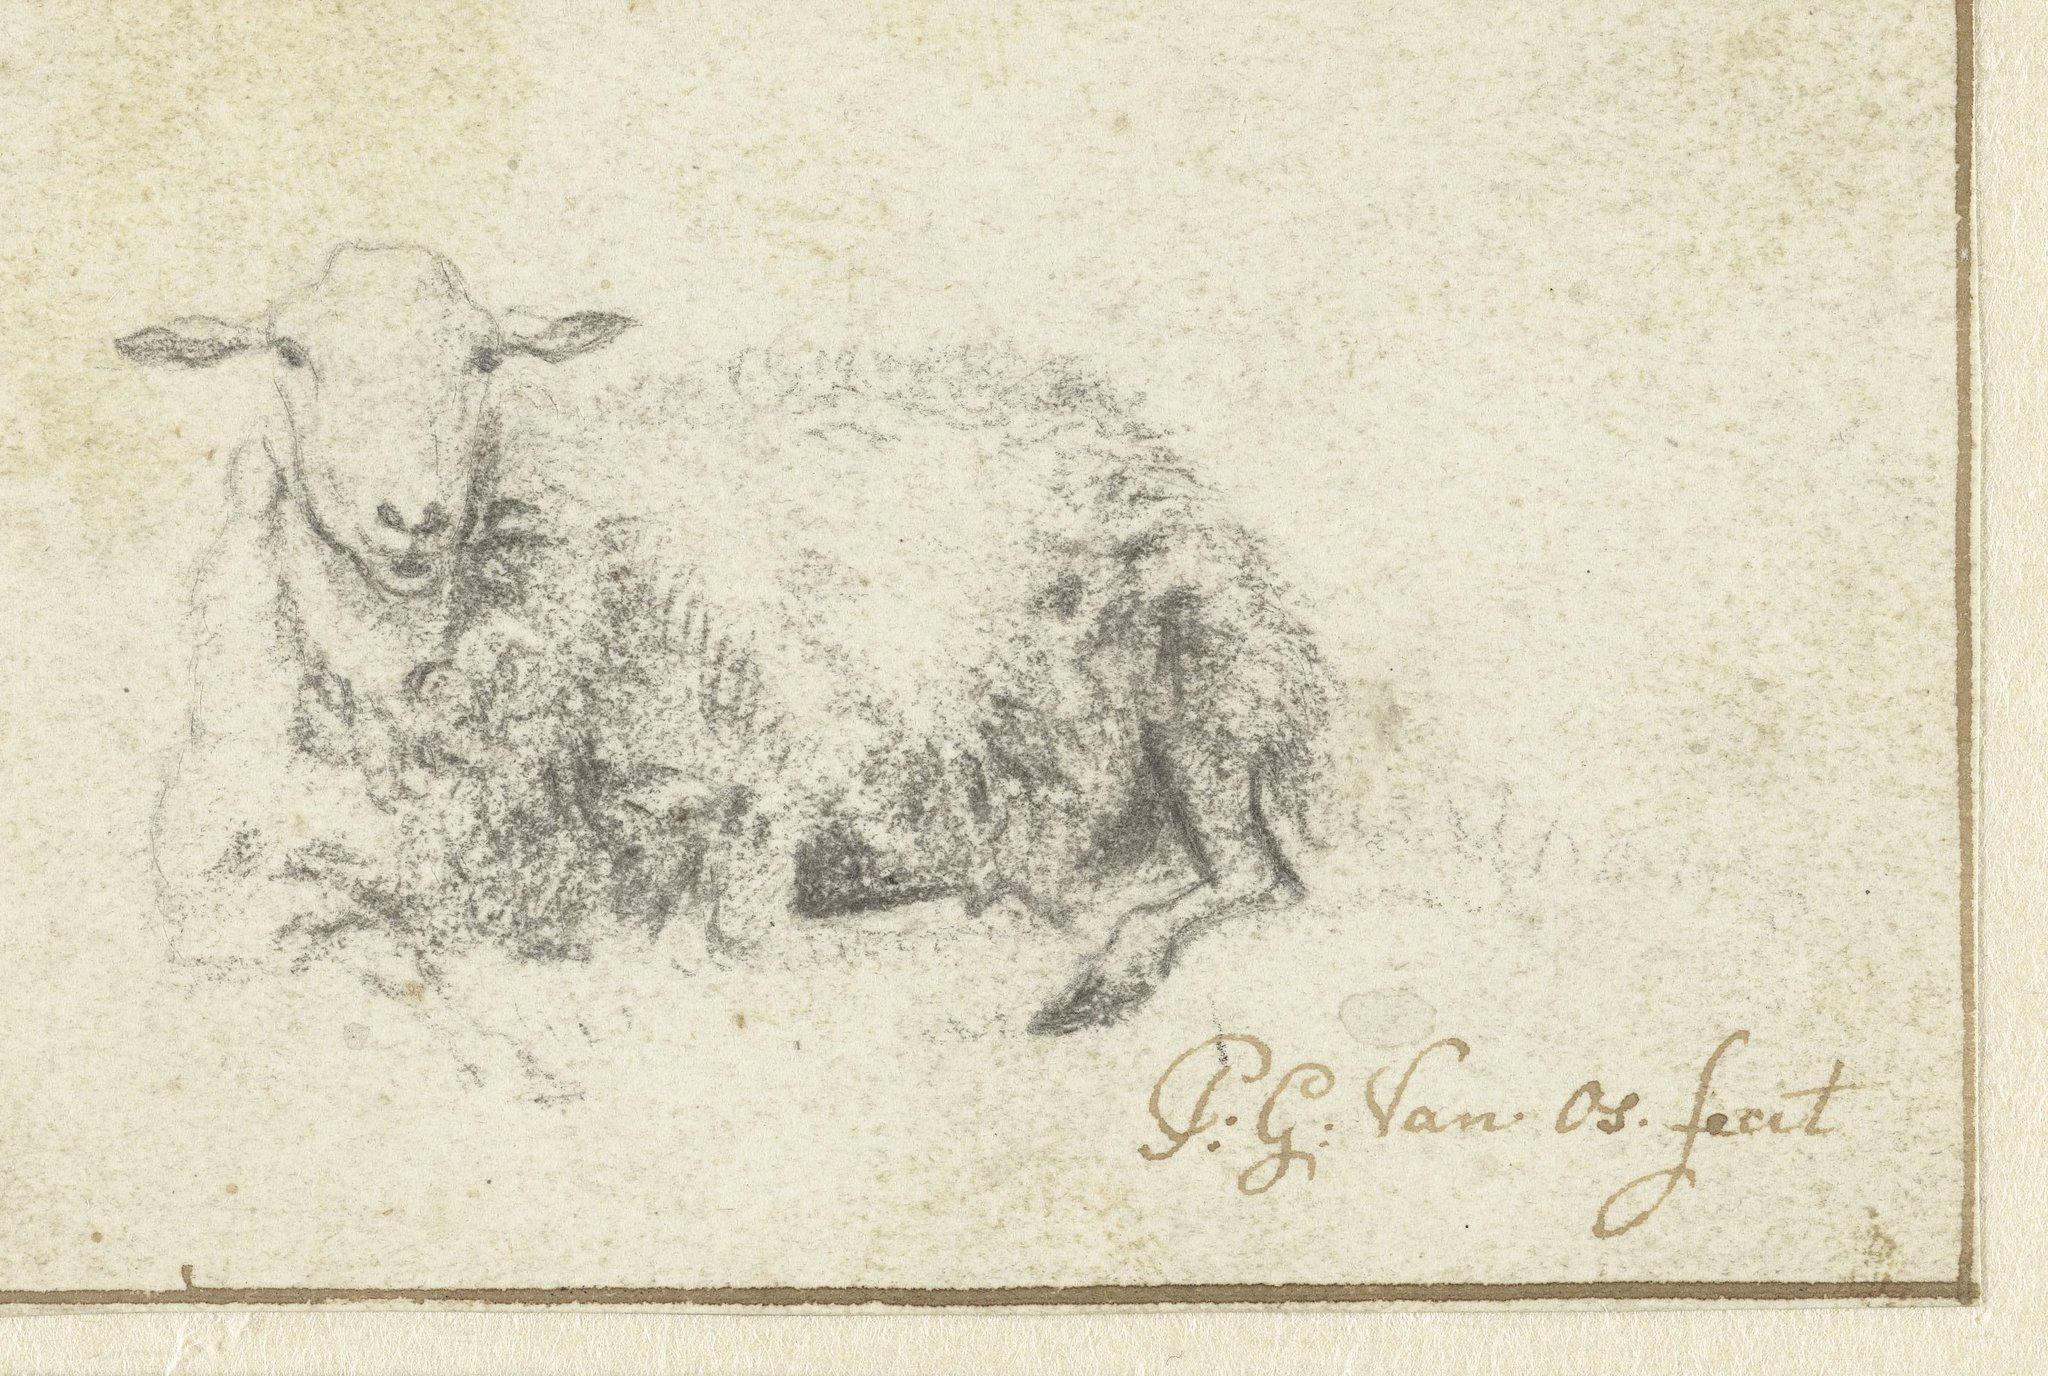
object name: drawing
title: Liggend schaap, van voren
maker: pieter gerardus van os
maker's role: draughtsman, painter, print maker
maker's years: 1776-1839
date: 1786-1839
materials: paper, pencil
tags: sheep